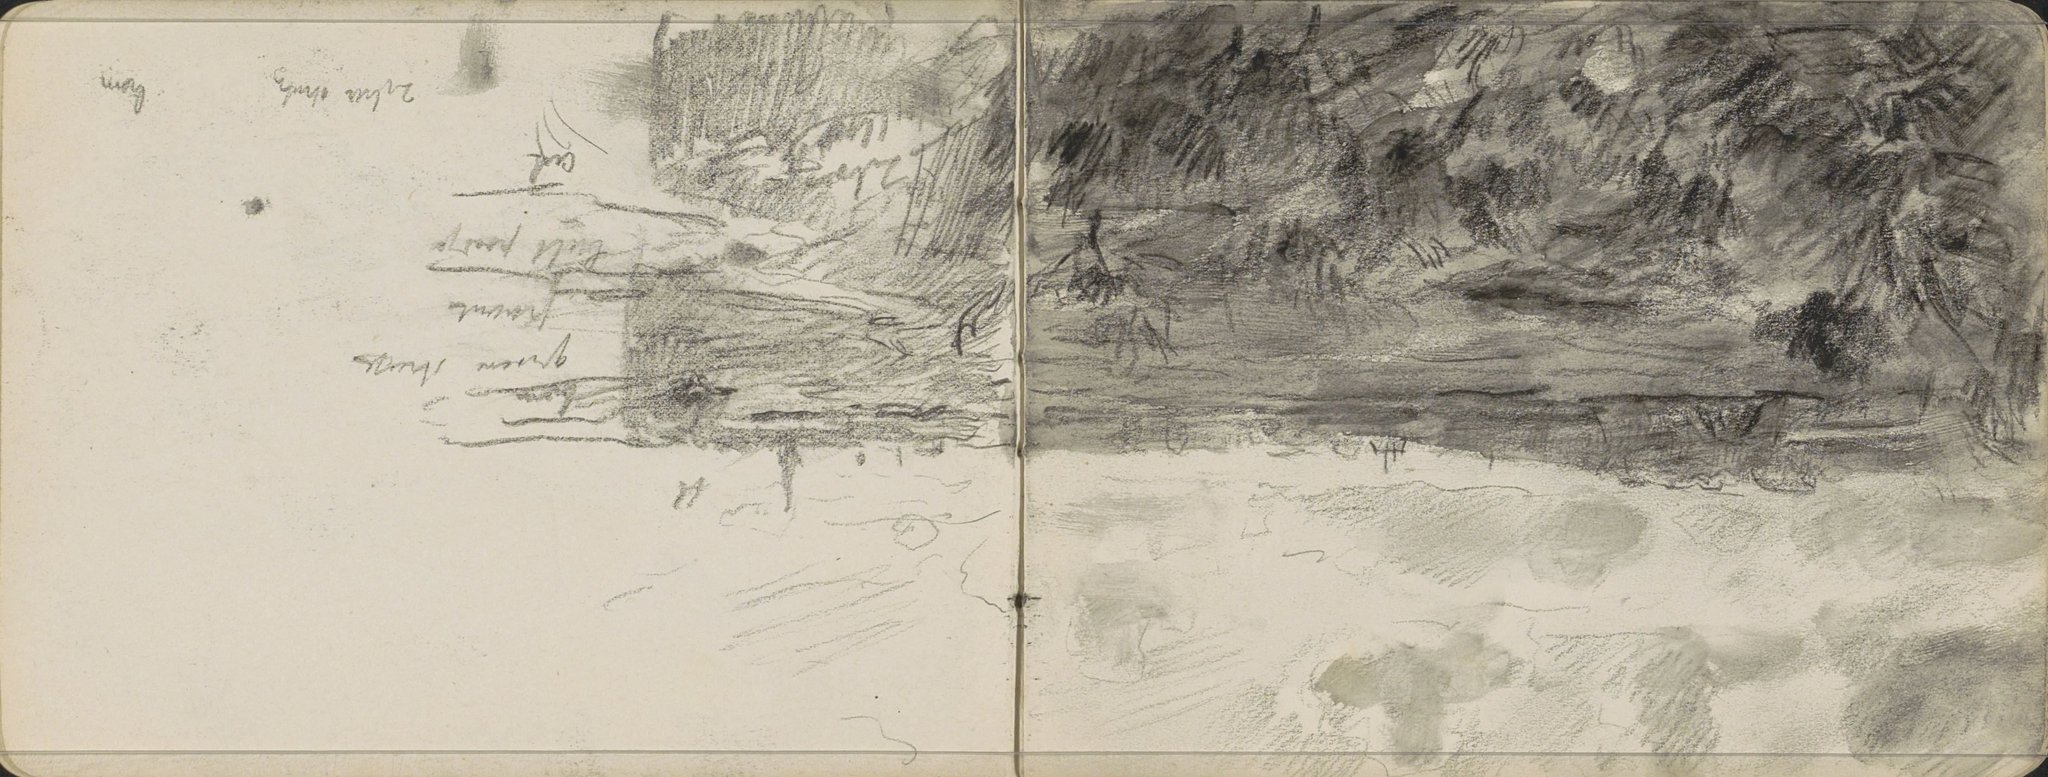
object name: sketchbook leaf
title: Landschap, mogelijk een duinlandschap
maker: johan antonie de jonge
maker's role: draughtsman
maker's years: 1864-1927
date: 1884-1927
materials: chalk, paper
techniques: stumping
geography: south holland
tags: dune coast, tower (of house or building)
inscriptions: kleurnotitie, handgeschreven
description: Landschap, mogelijk een duinlandschap. In de verte een toren. Blad 8 verso en blad 9 recto uit een schetsboek met 33 bladen.